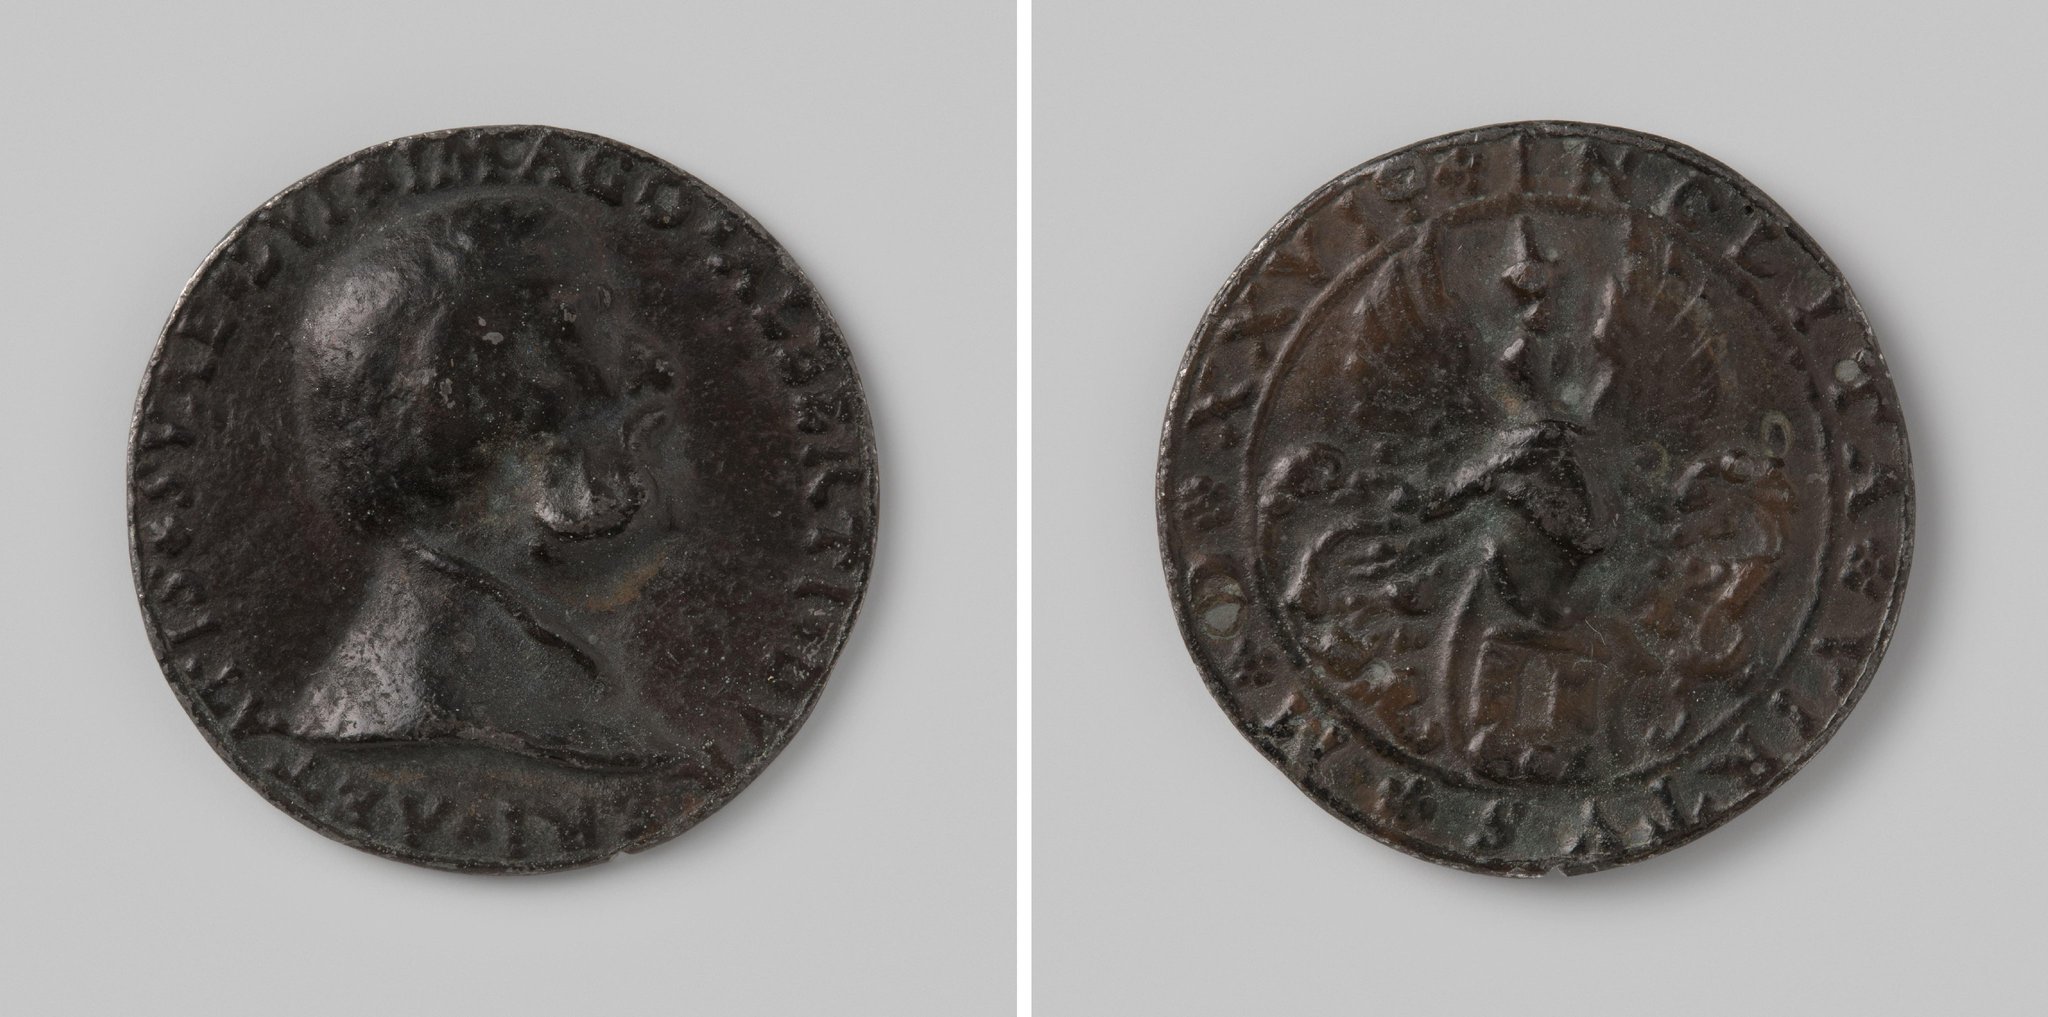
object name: history medal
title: Albrecht Dürer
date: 1528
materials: lead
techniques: casting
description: Gegoten penning van zwart gepatineerd lood, op de voorzijde het portret van Dürer naar rechts met omschrift, op de keerzijde een gehelmd wapenschild met omschrift.